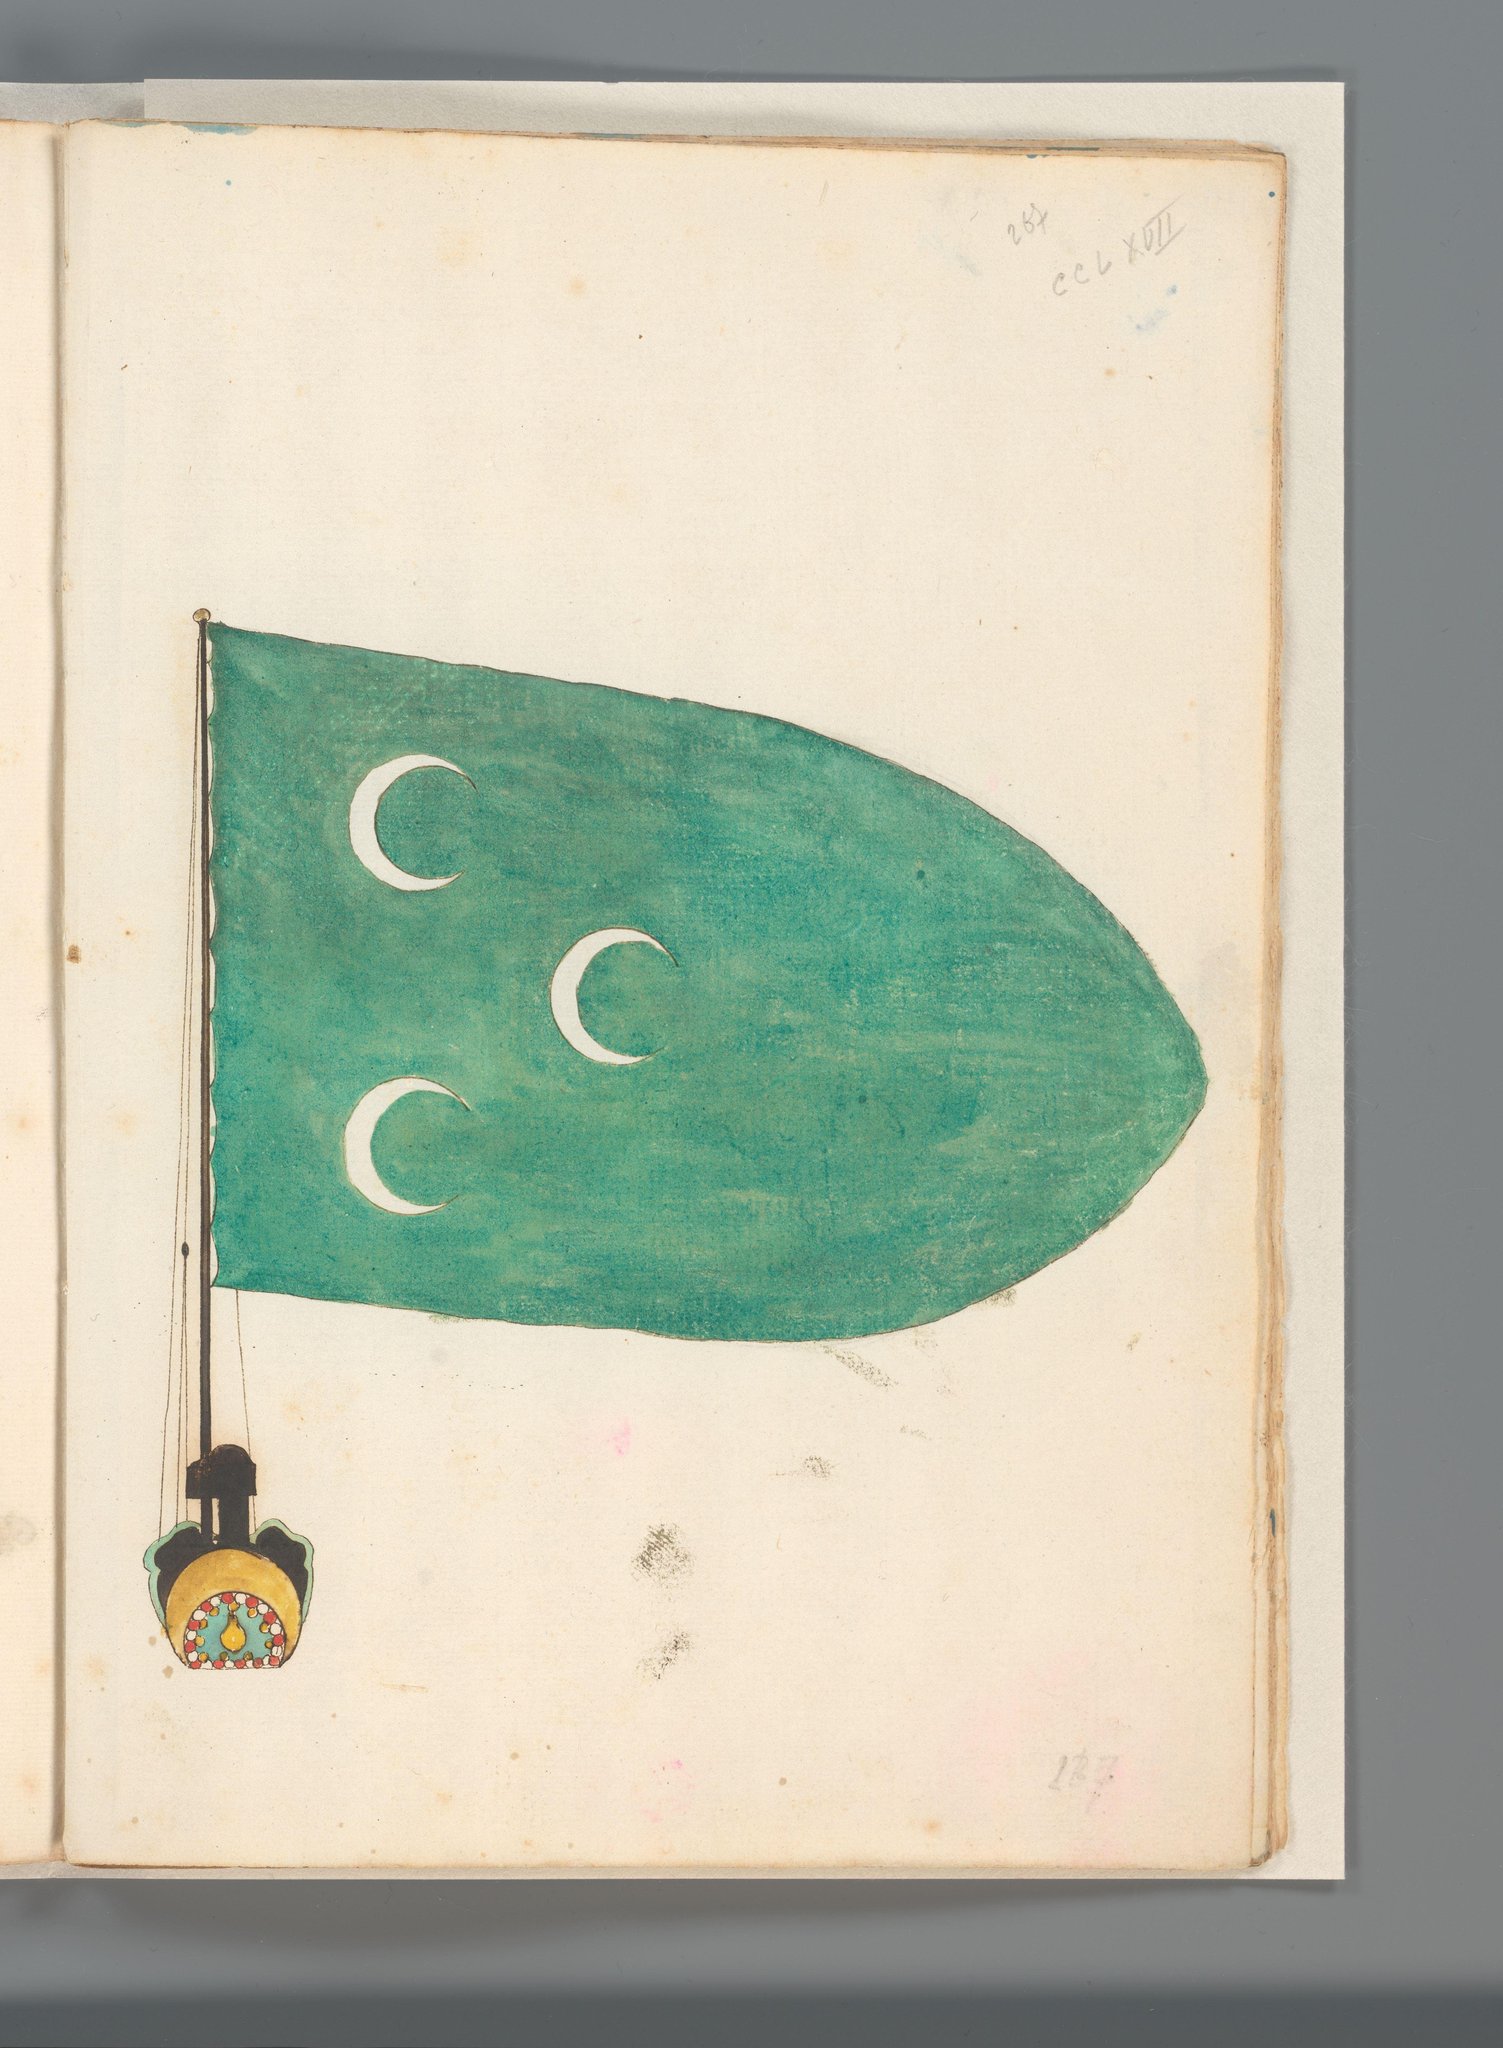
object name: drawing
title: Vlag van Tripolitanië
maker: Anonymous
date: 1667-1670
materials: ink, paper, watercolor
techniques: brush, pen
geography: france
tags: flag, colours (as symbol of the state, etc.)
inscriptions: number: ‘267 / CCLXVII / 267’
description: Vlag van Tripolitanië (Tripolitania). Groene vlag met drie halve manen, met afgeronde vluchtzijde. Vlag op vlaggensteng en mastvoet. Afgebeeld op folio 134r. Onderdeel van een vlaggenboek met vlaggen uit Europa, Noord-Afrika, Nabije en Verre Oosten.